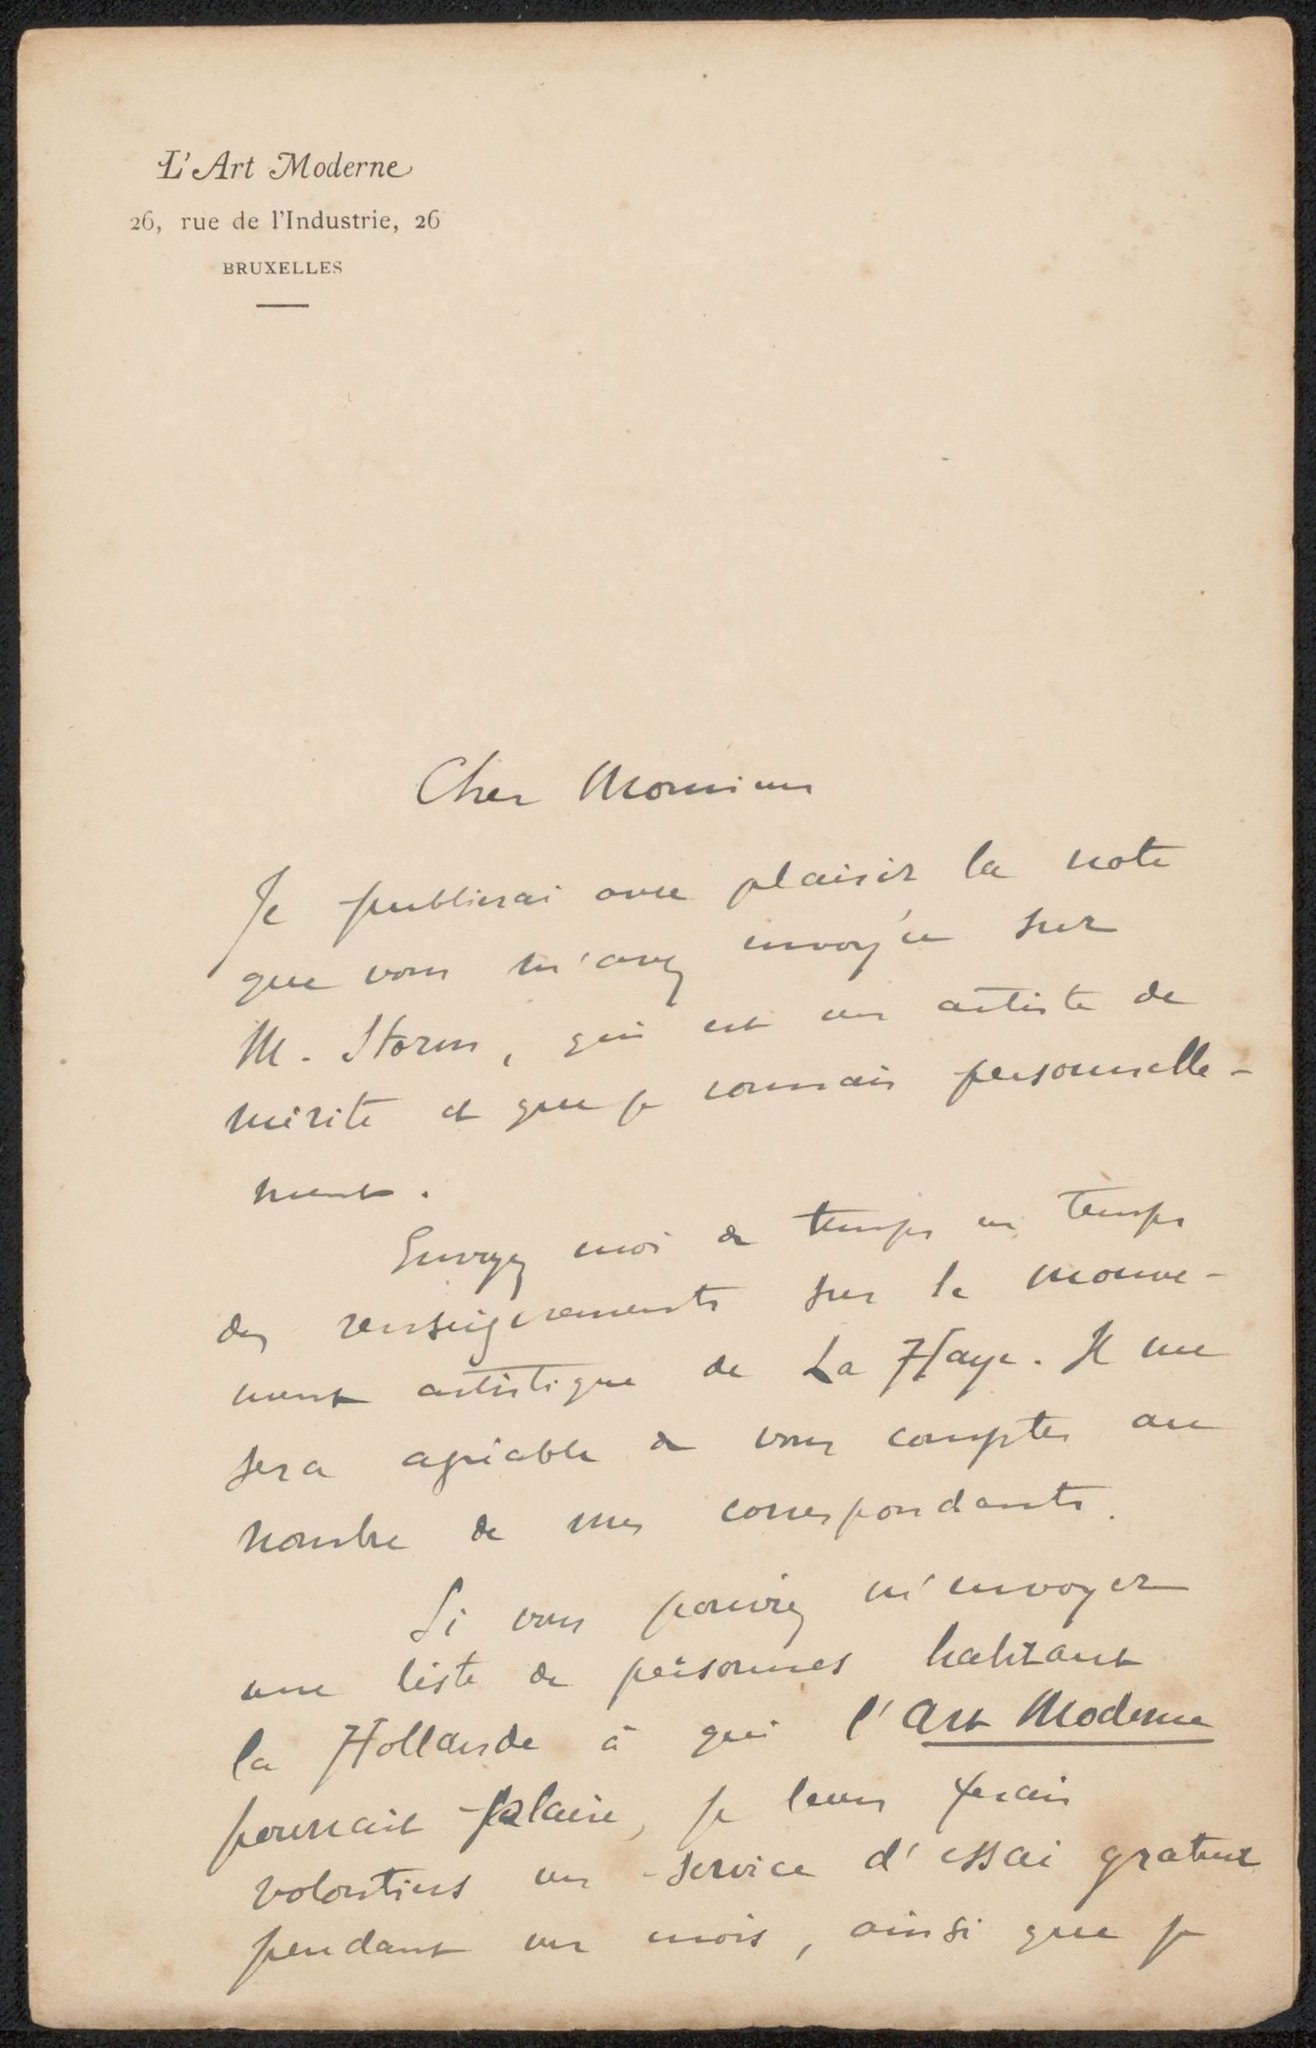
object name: letter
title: Brief aan Philip Zilcken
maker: octave maus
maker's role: painter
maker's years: 1856-1919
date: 1884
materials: ink, paper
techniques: pen, printing, writing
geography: brussels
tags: print maker, draughtsman, carel nicolaas storm van 's-gravesande, painter, philip zilcken, literature ~ arts, the hague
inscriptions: collector's mark: ‘RPK’